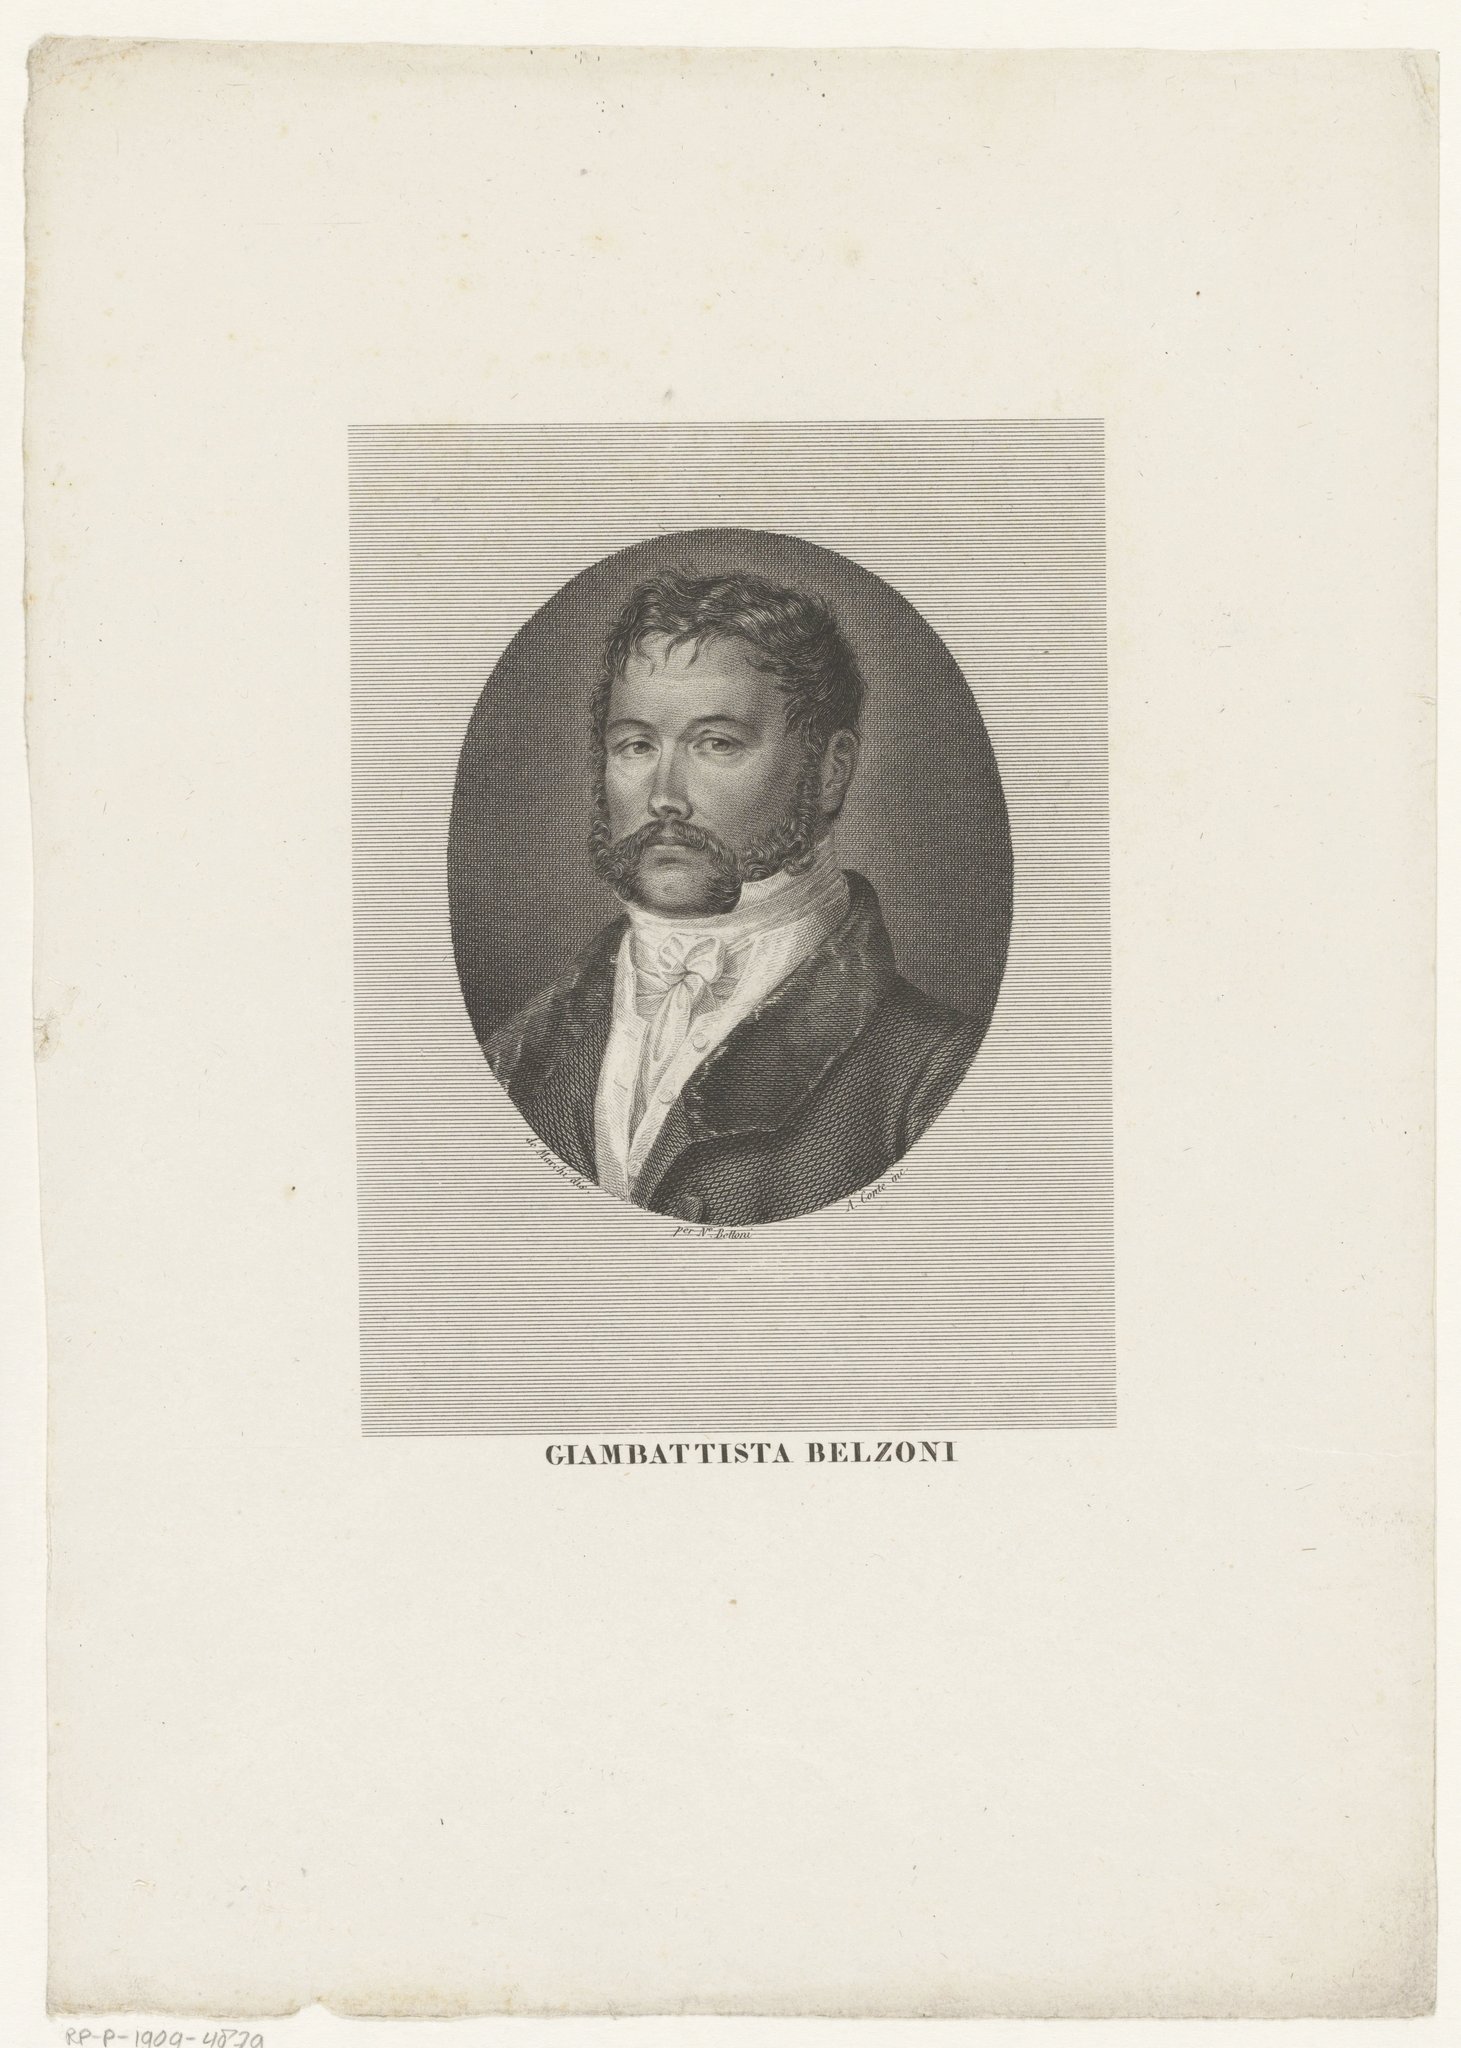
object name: print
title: Portret van Giovanni Battista Belzoni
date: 1790-1837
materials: paper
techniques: engraving, etching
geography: italy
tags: giovanni battista belzoni, historical persons, exploration, expedition, voyage of discovery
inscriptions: collector's mark: Lugt 2228